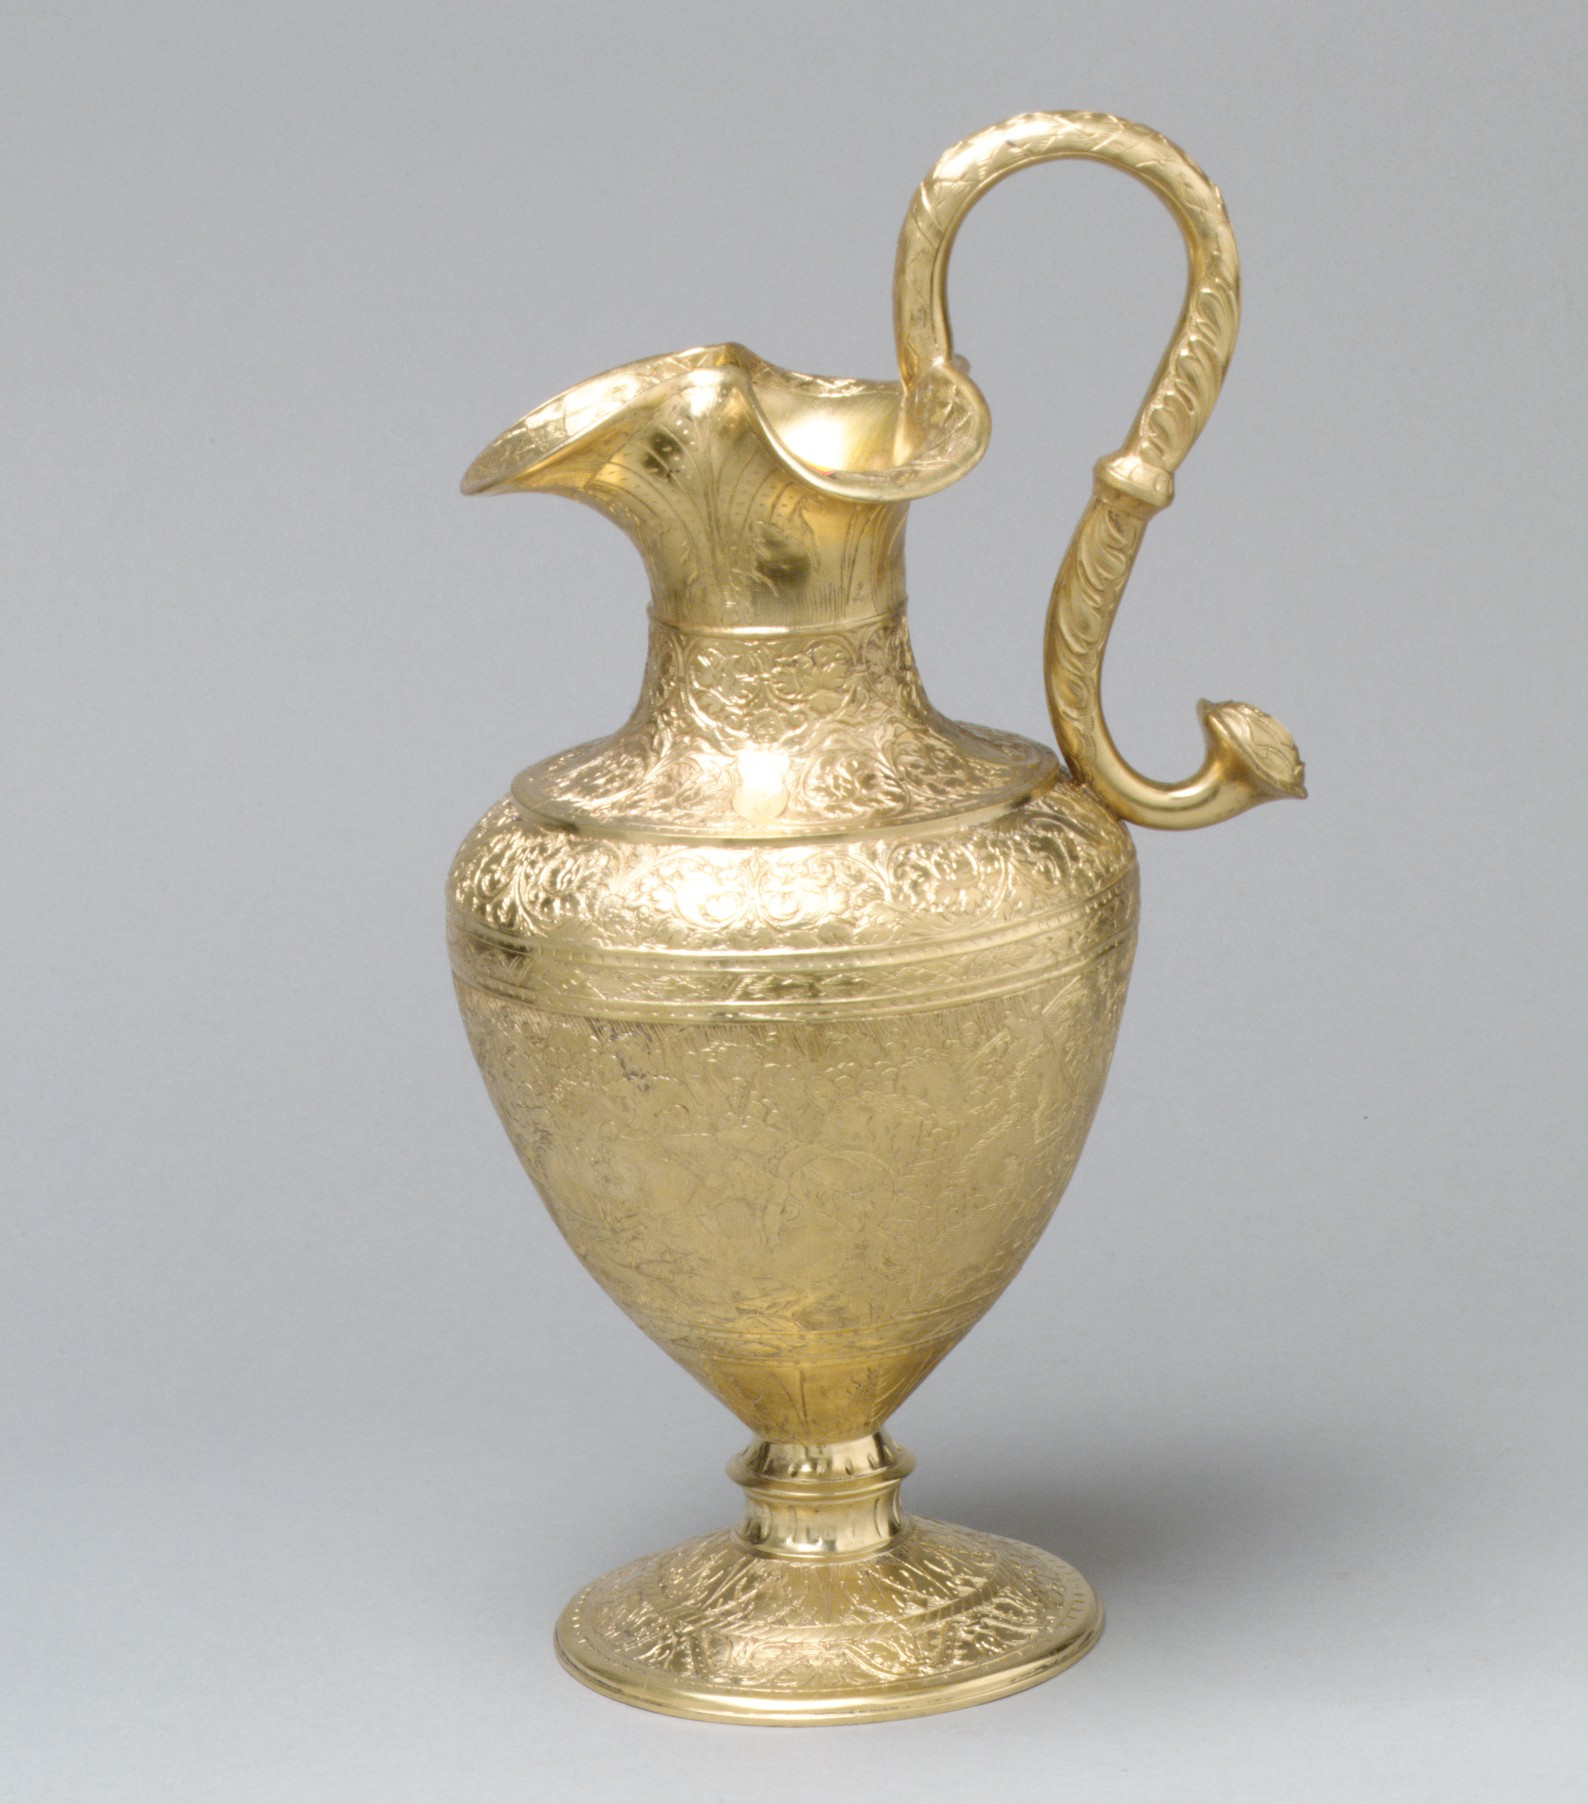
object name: ewer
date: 1801-1900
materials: brass, gilt bronze